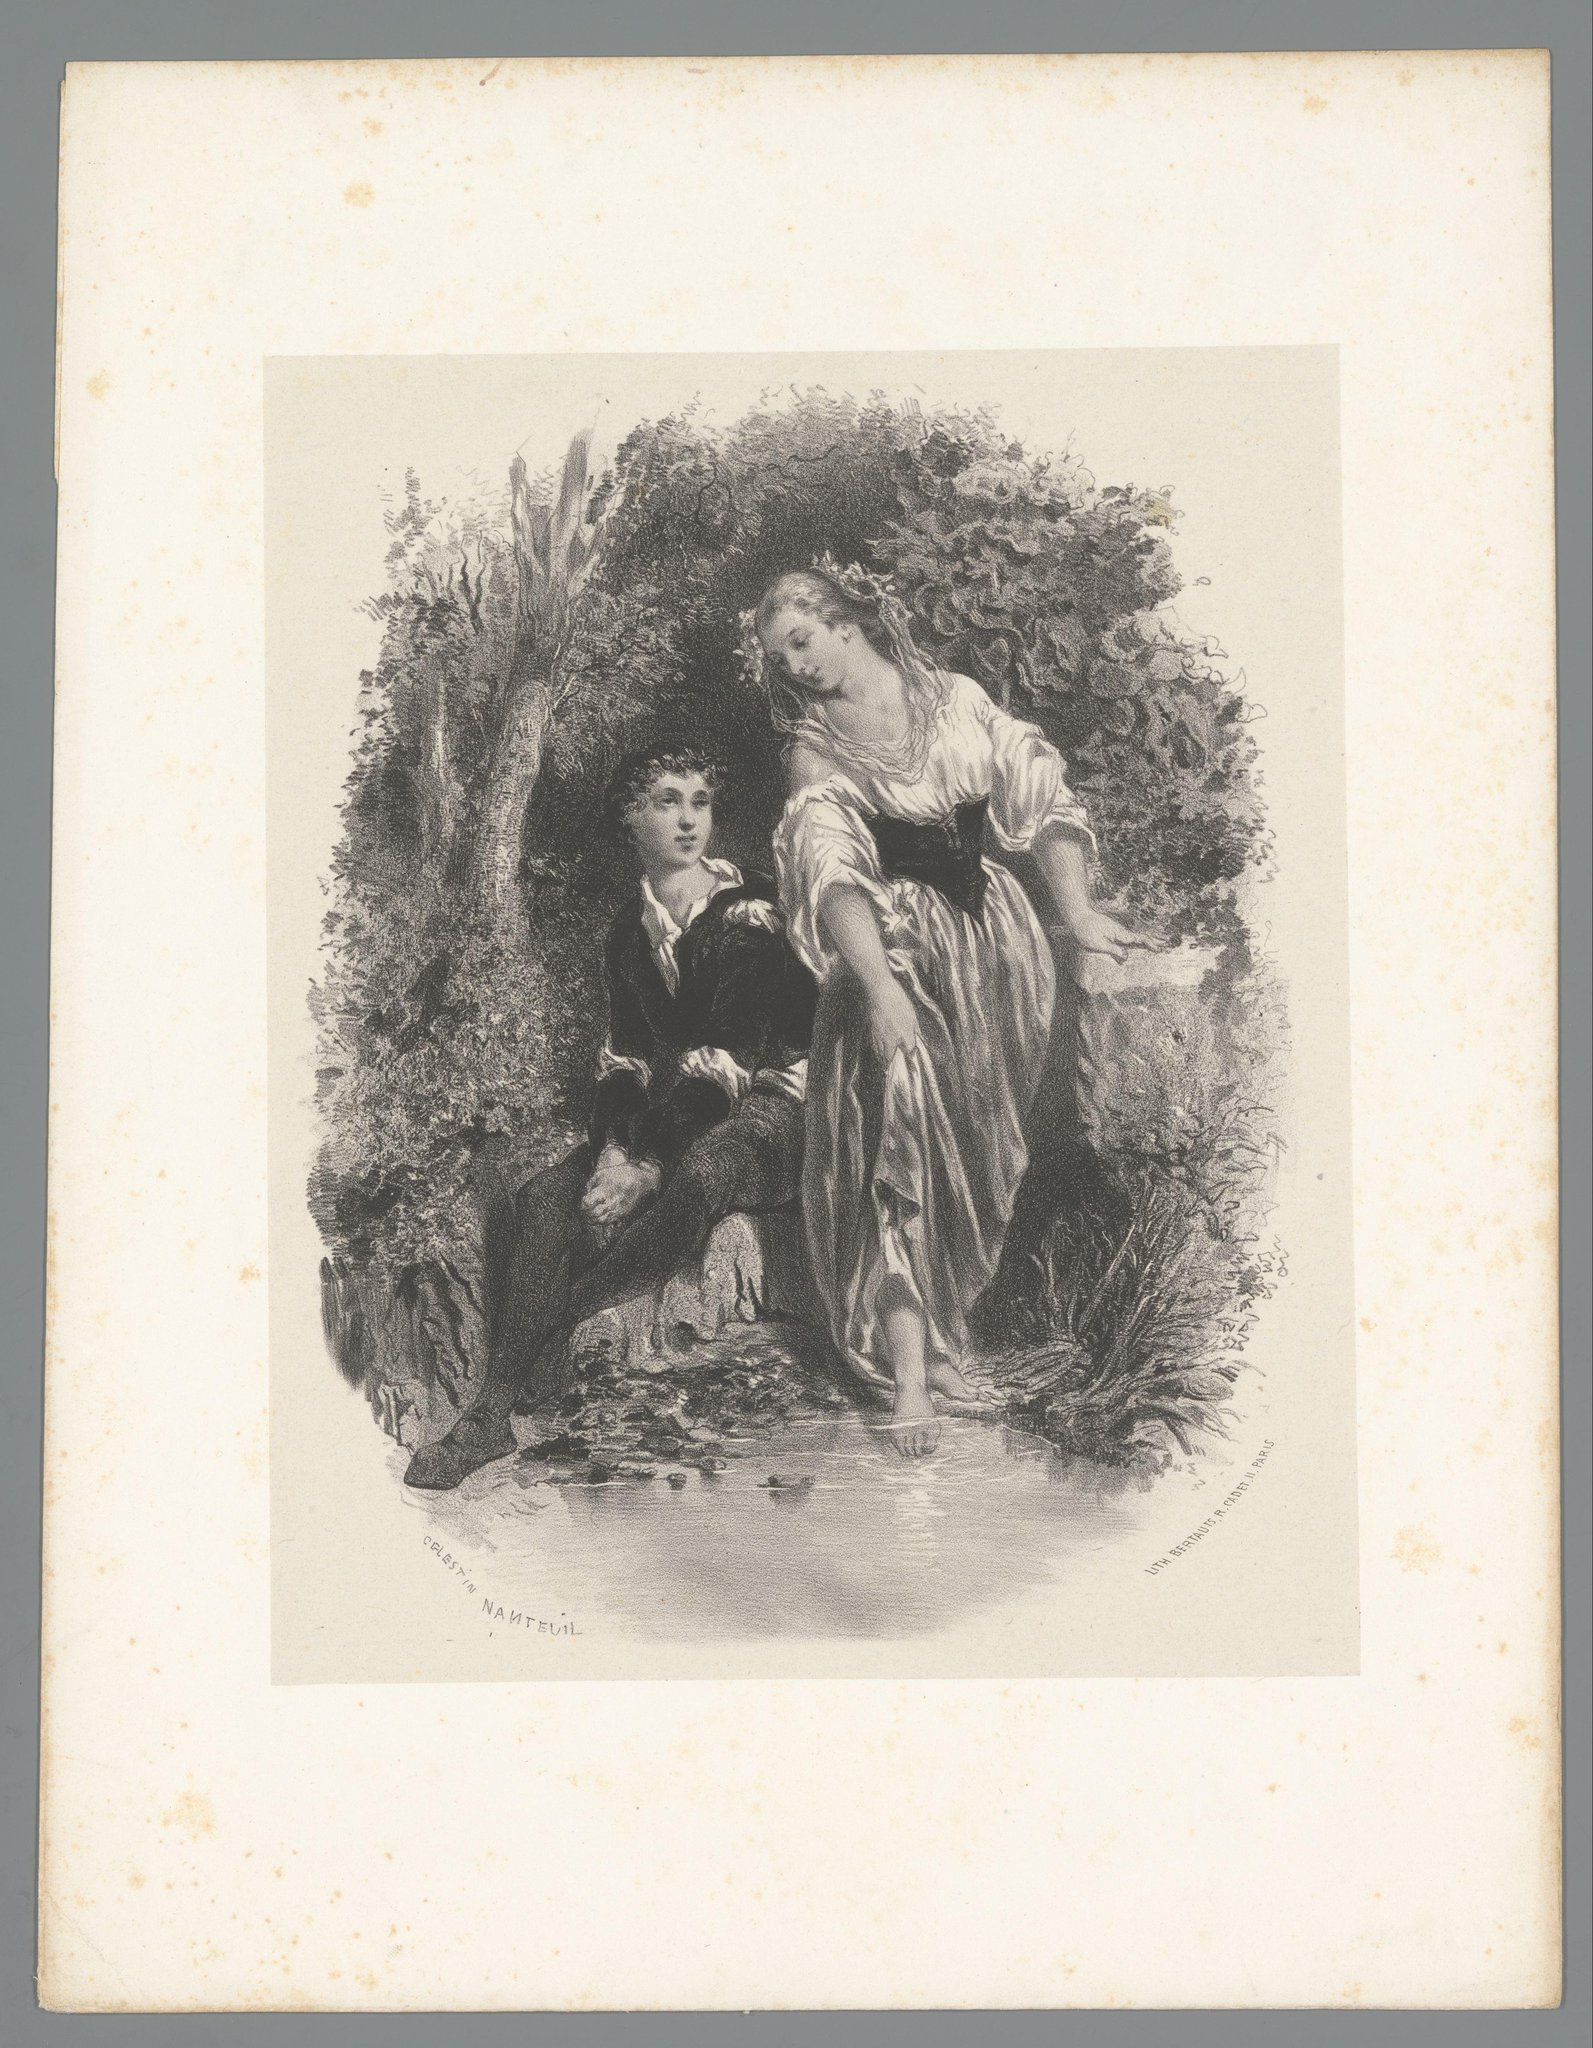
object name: print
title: Jonge man en vrouw bij een ven in het bos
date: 1851-1865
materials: paper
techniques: lithograph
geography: paris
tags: forest, wood, lovers' meeting, fen, du. 'ven', couple of lovers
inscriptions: collector's mark: Lugt 964